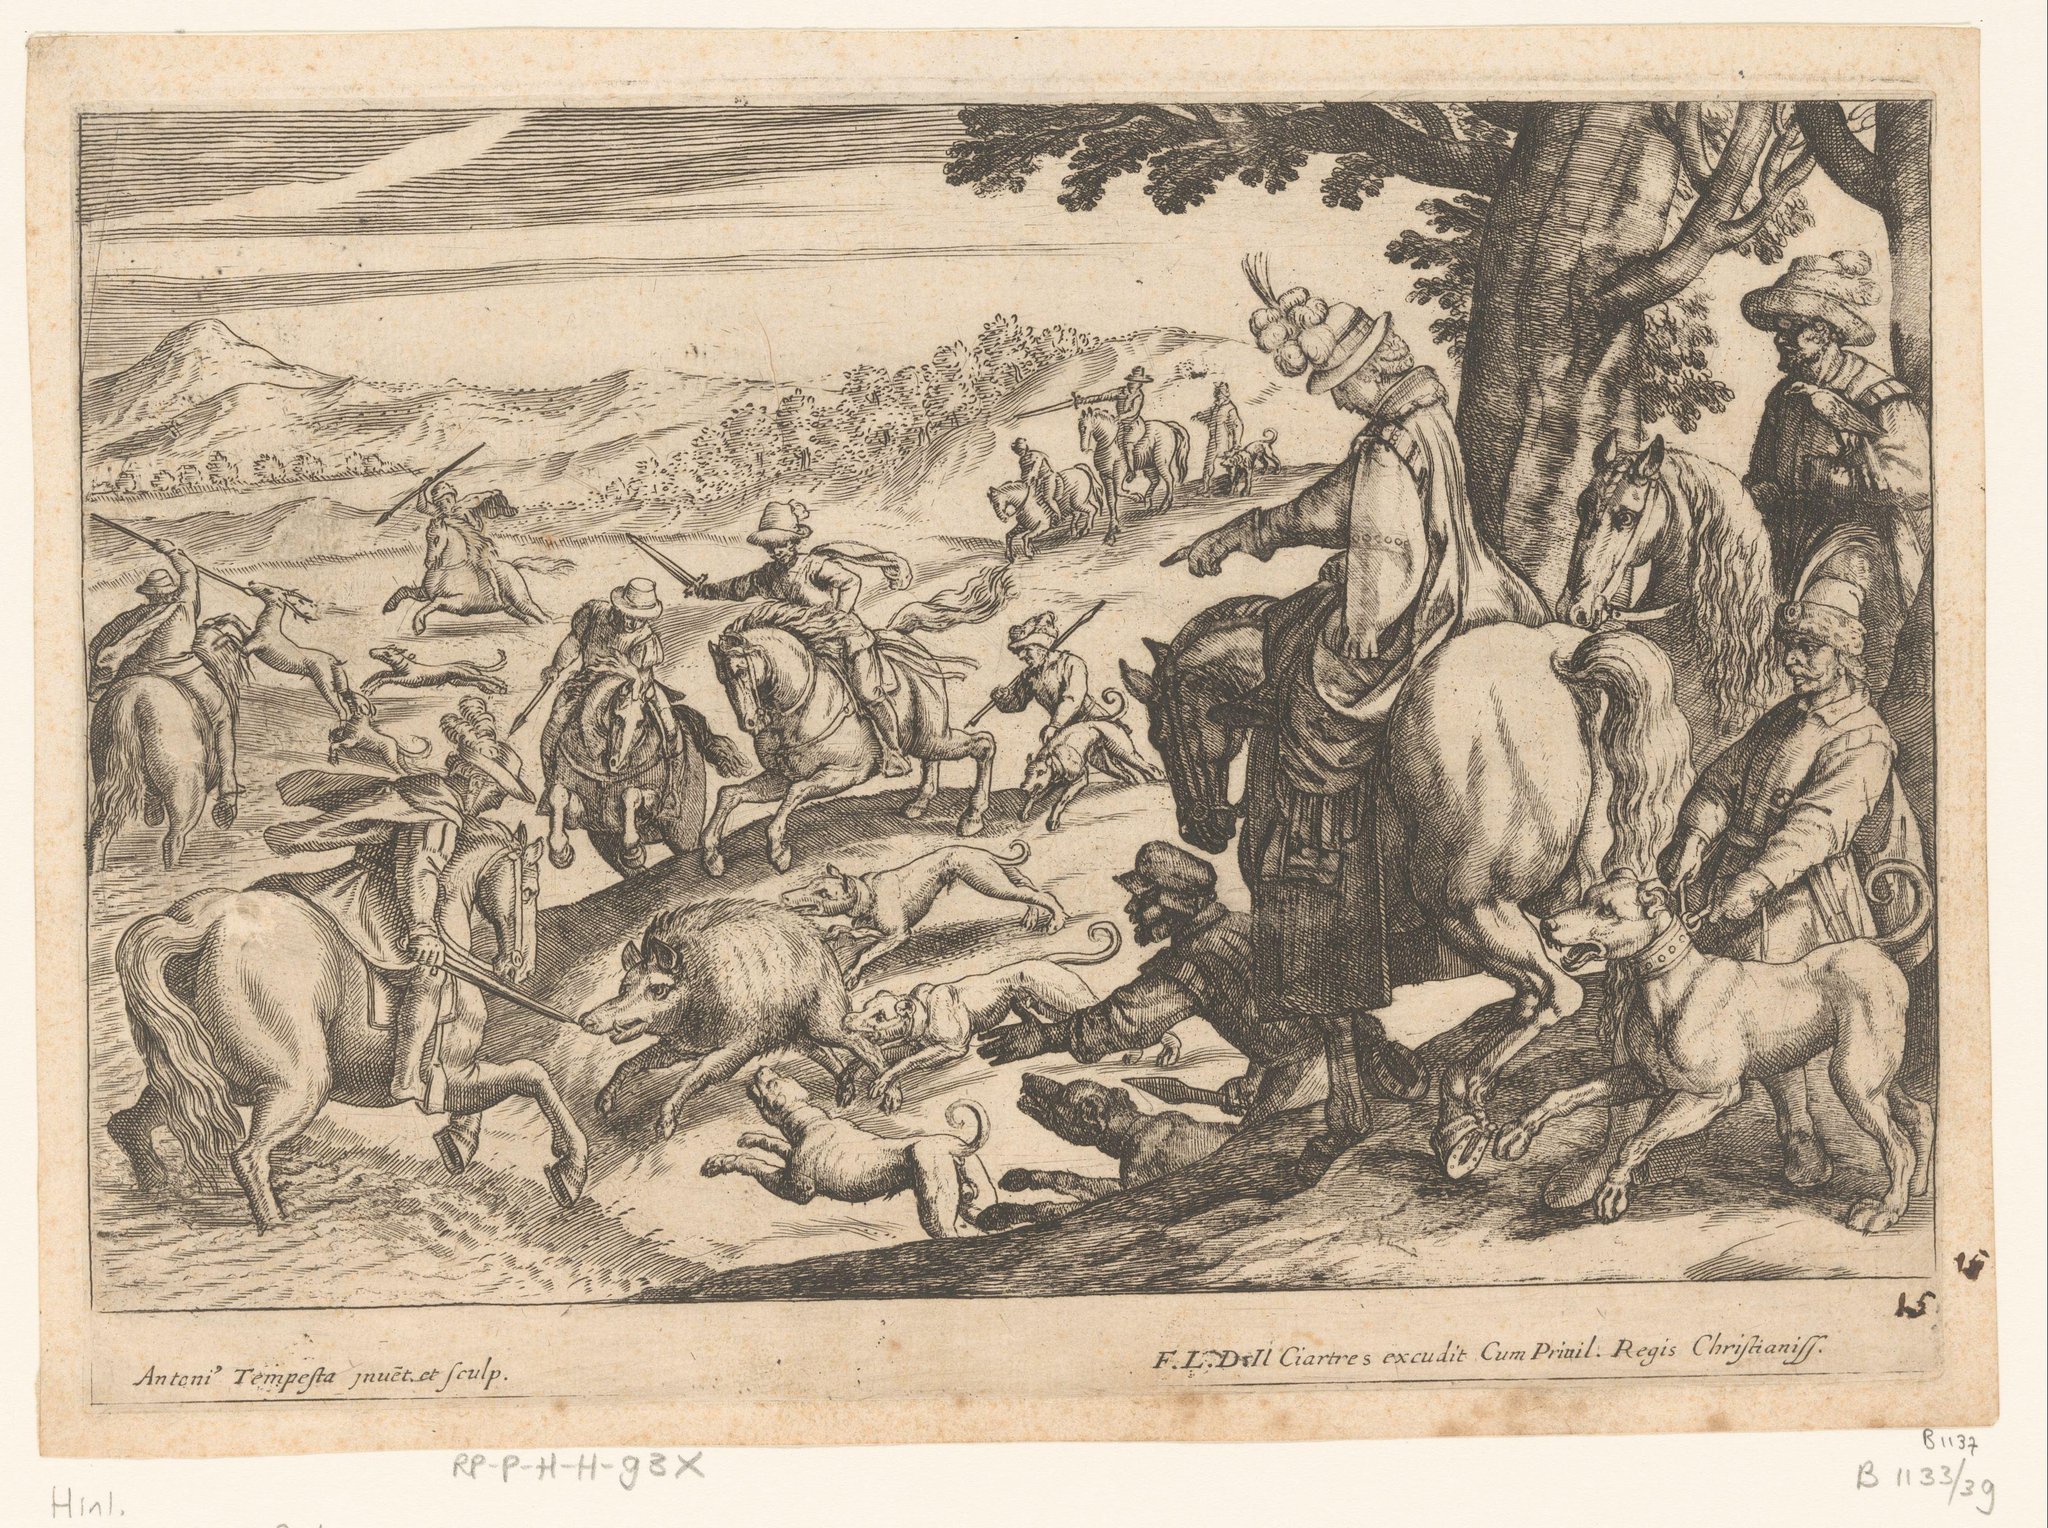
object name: print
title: Jachtscènes (deel 5)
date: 1600-1620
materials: paper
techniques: etching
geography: italy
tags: hunting dogs, boar-hunting, hunter, hunters hunting (n.b.: in 1988-1990 this notation denoted the concept of 43c11421 'hunters resting during the hunt')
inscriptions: collector's mark: Lugt 11, number: ‘15’, collector's mark: ‘Hinloopen’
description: Deze prent maakt deel uit van een reeks van zeven prenten met jachtscènes.